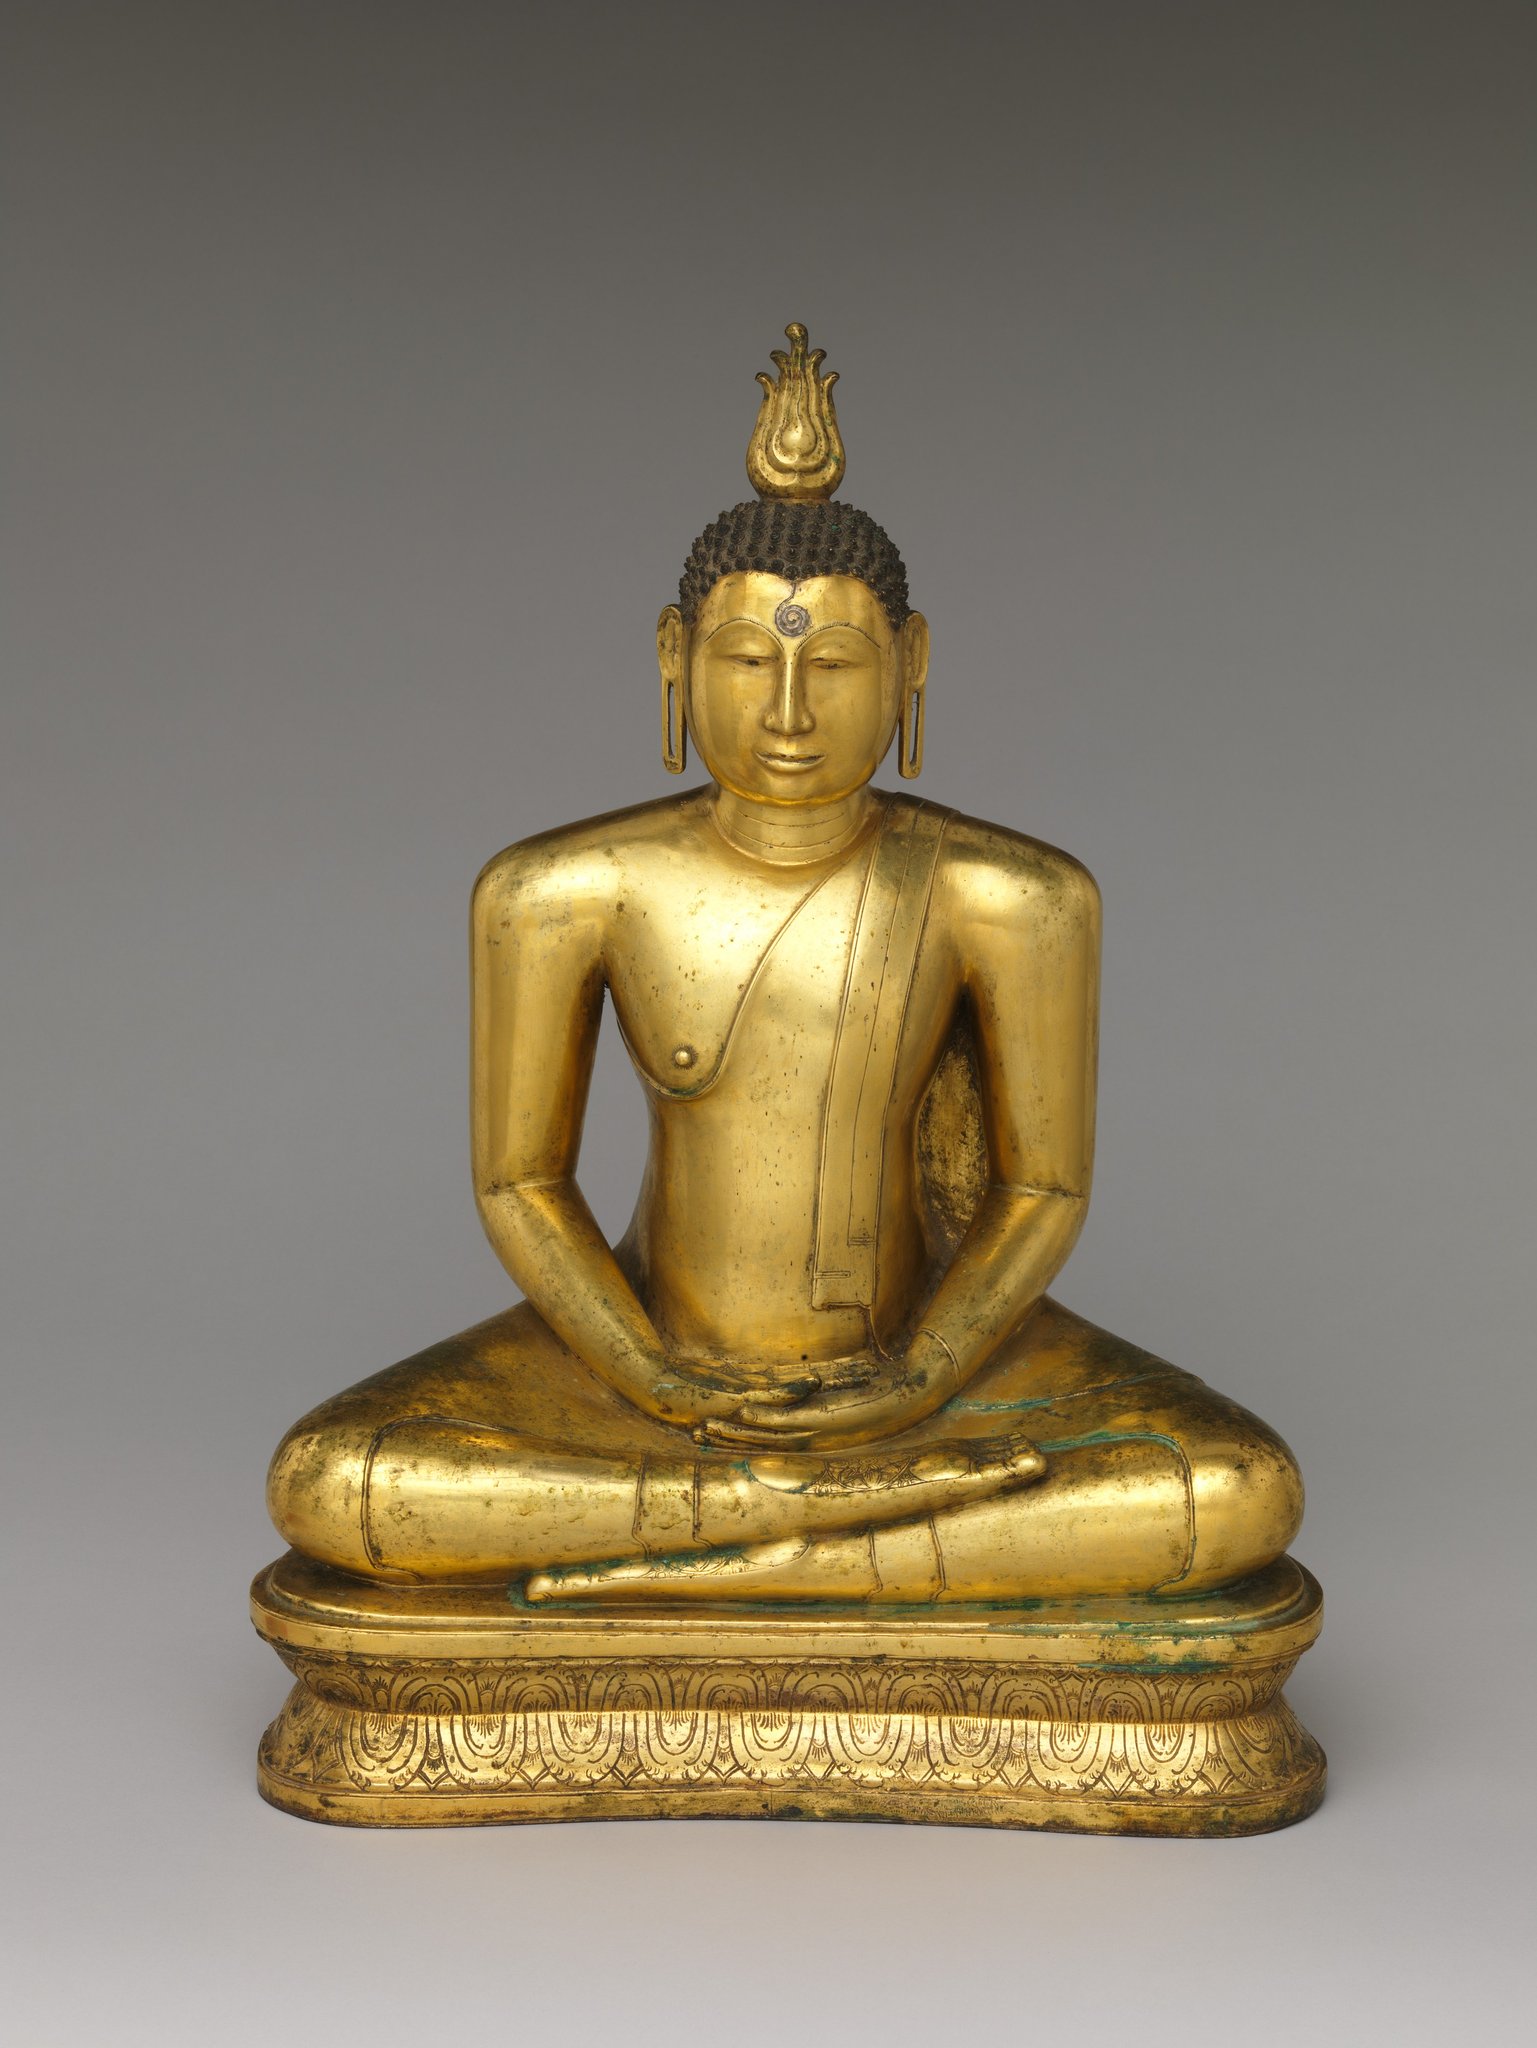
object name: figure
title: Buddha Seated in Meditation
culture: sri lankan, western regions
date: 1501-1600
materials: copper alloy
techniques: gilding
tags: buddhism,buddha